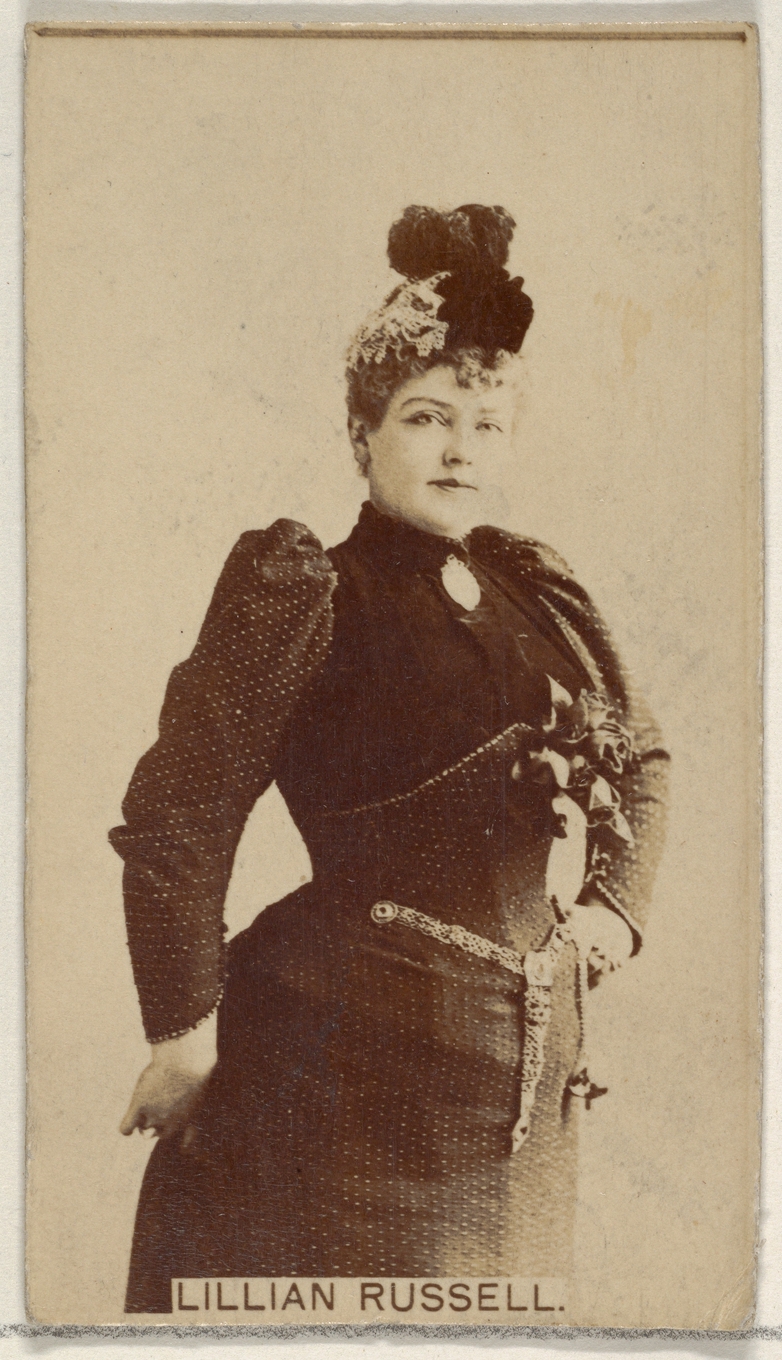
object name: photograph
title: Lillian Russell, from the Actors and Actresses series (N45, Type 8) for Virginia Brights Cigarettes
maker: allen & ginter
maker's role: publisher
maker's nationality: american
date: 1888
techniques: albumen silver print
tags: portraits,women,actresses